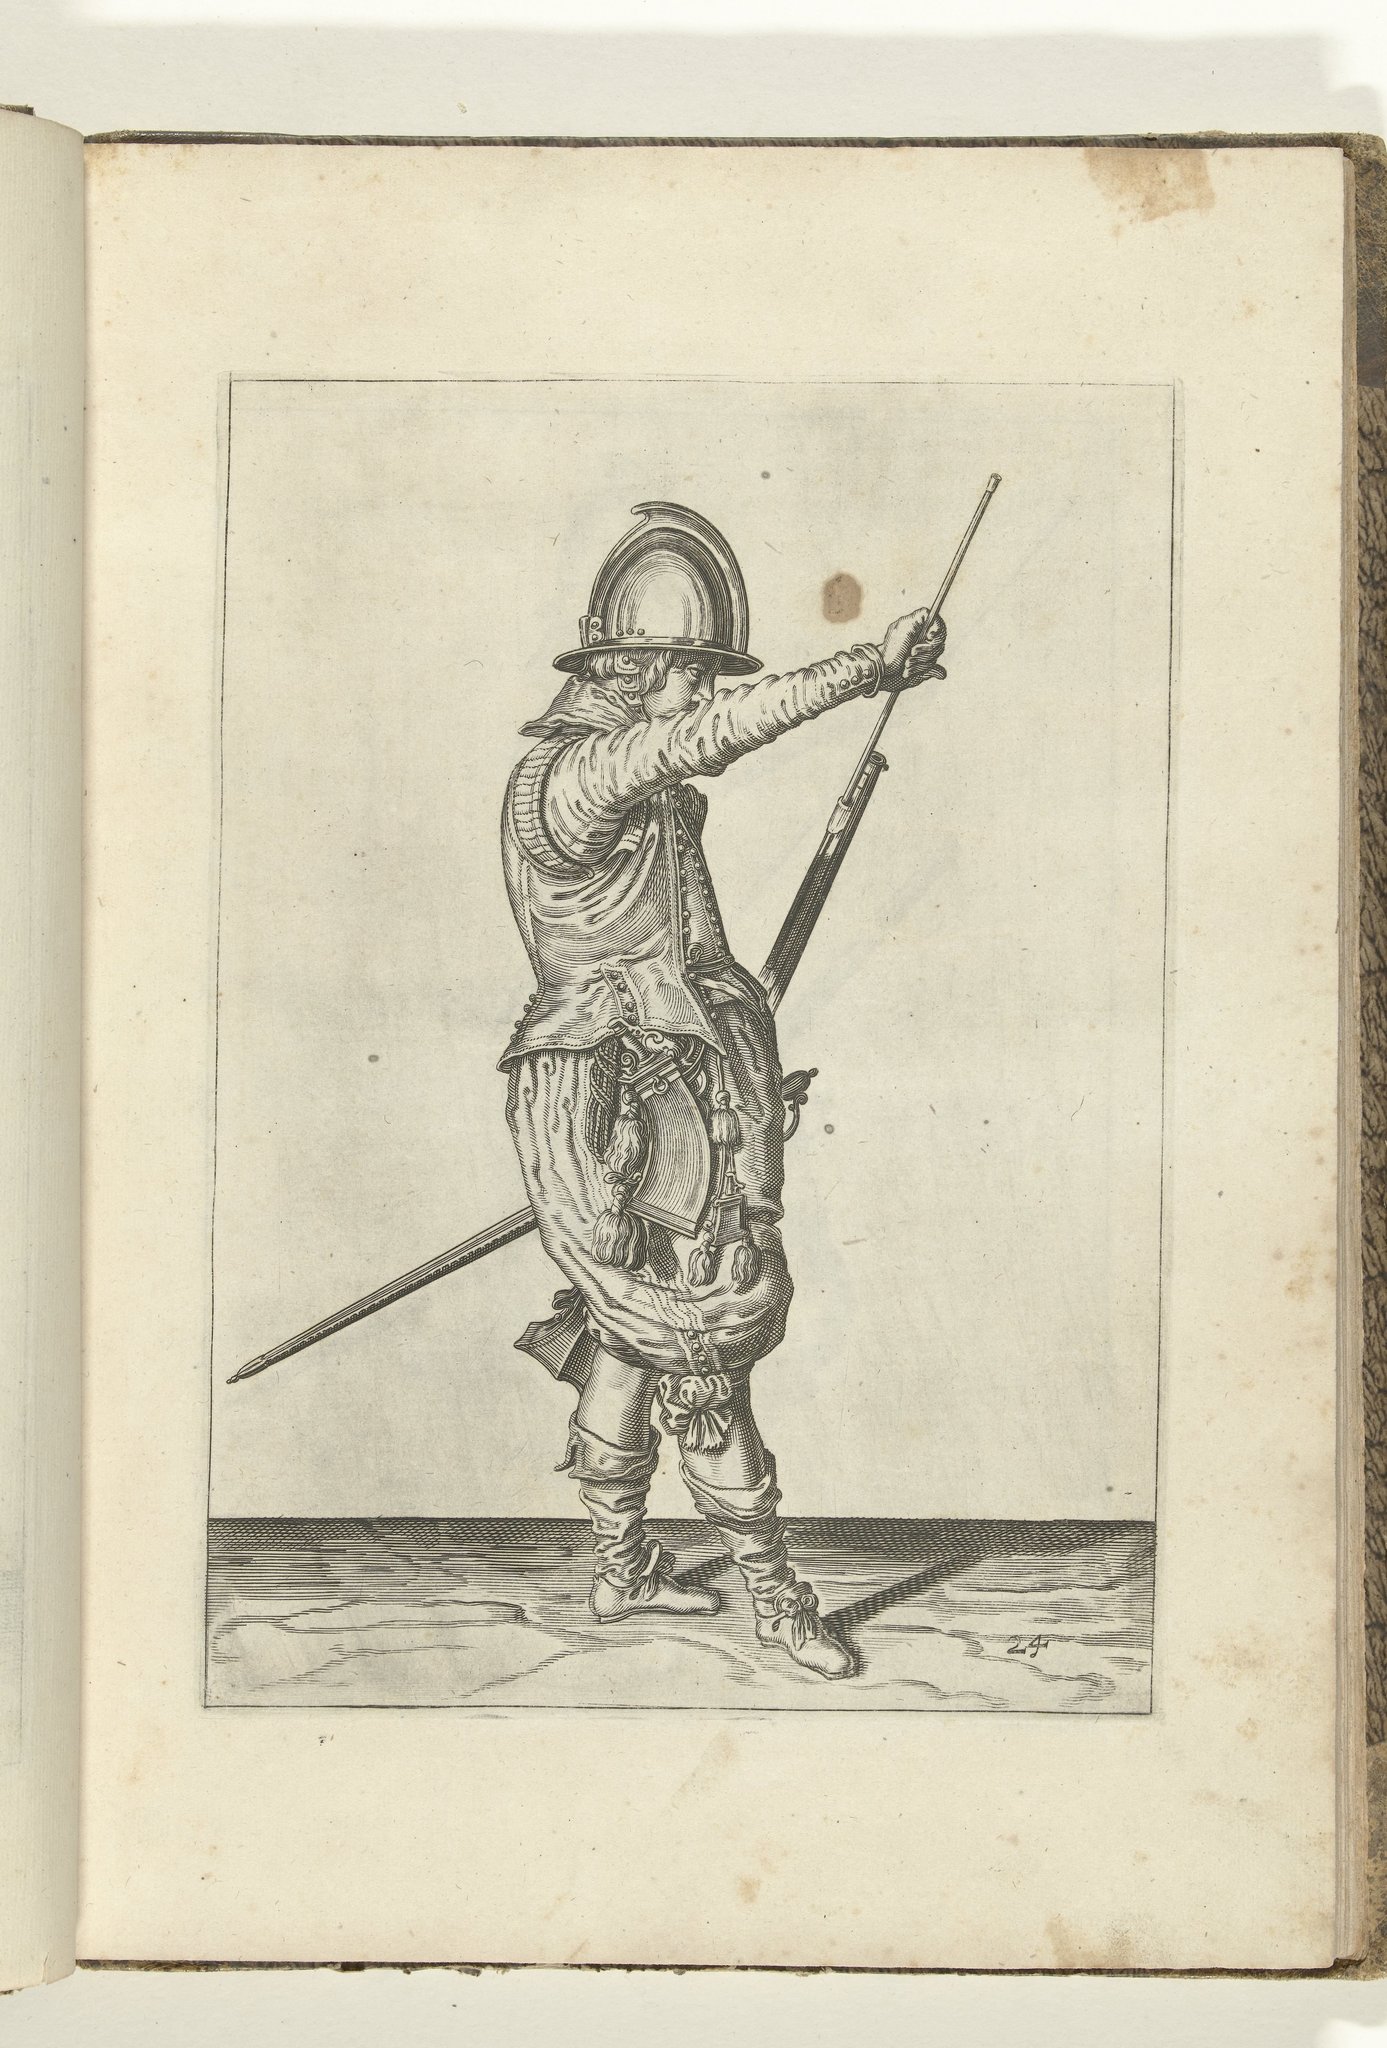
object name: print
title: Soldaat die zijn laadstok uit de houder onder de loop van zijn roer haalt (nr. 24), ca. 1600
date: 1597-1608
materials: paper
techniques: engraving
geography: northern netherlands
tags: maurice (prince of orange), handling of weapons ~ military training, weapons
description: Een soldaat, ten voeten uit, naar rechts, die met zijn linkerhand bij zijn linkerdijbeen een roer (een bepaald type vuurwapen) vasthoudt en met zijn rechterhand de laadstok uit de houder onder de loop haalt (nr. 24), ca. 1600. Plaat 24 in de instructies voor het hanteren van de roer: Brief enseignement, sur la representation des figures, du droit maniement de l'Harquebuse. Onderdeel van de illustraties in een Franse editie van J. de Gheyns Wapenhandelinghe: J. de Gheyn, Maniement d'armes, d'arquebuses, mousquetz et piques : en conformité de l'ordre de Mour le Prince Maurice, Prince d'Orange, Amsterdam 1608. Krijgswezen rond 1600.